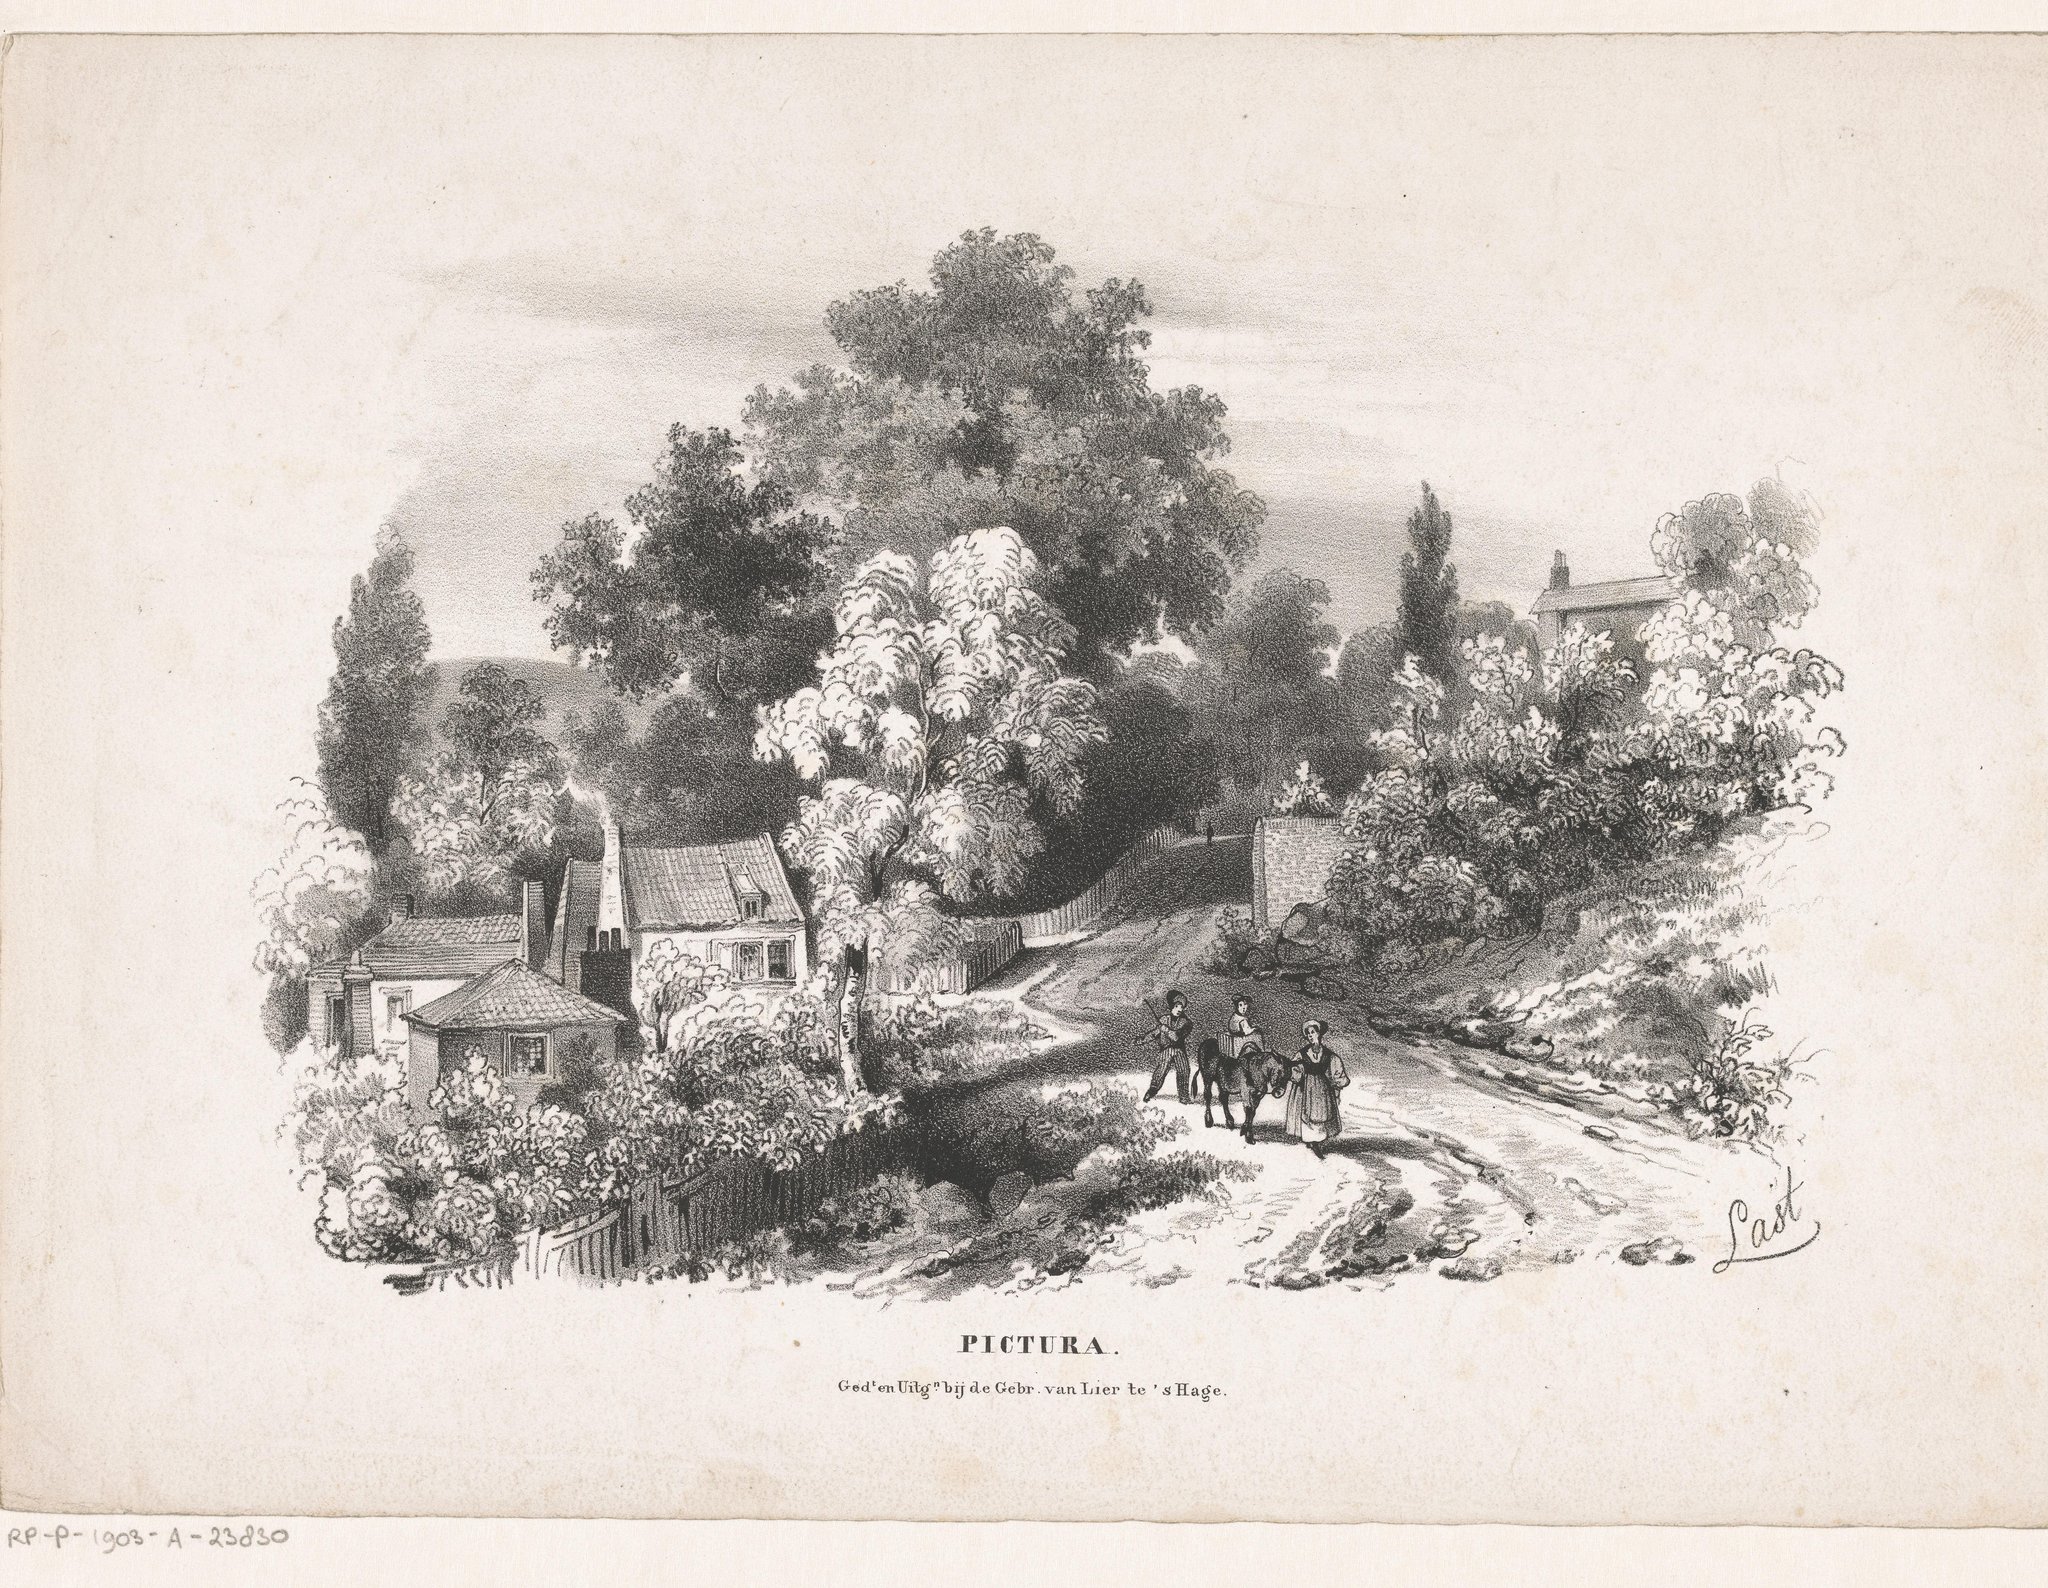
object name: print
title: Pictura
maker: carel christiaan antony last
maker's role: print maker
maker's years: 1808-1876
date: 1834-1850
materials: paper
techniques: lithograph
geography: the hague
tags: city-view, and landscape with man-made constructions, ass, donkey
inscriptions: collector's mark: Lugt 2228